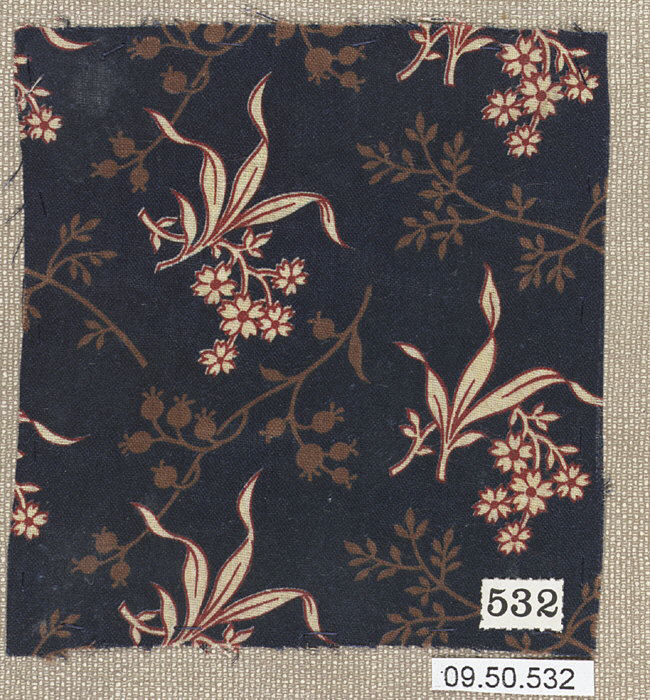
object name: piece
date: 1801-1900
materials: cotton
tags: flowers,leaves